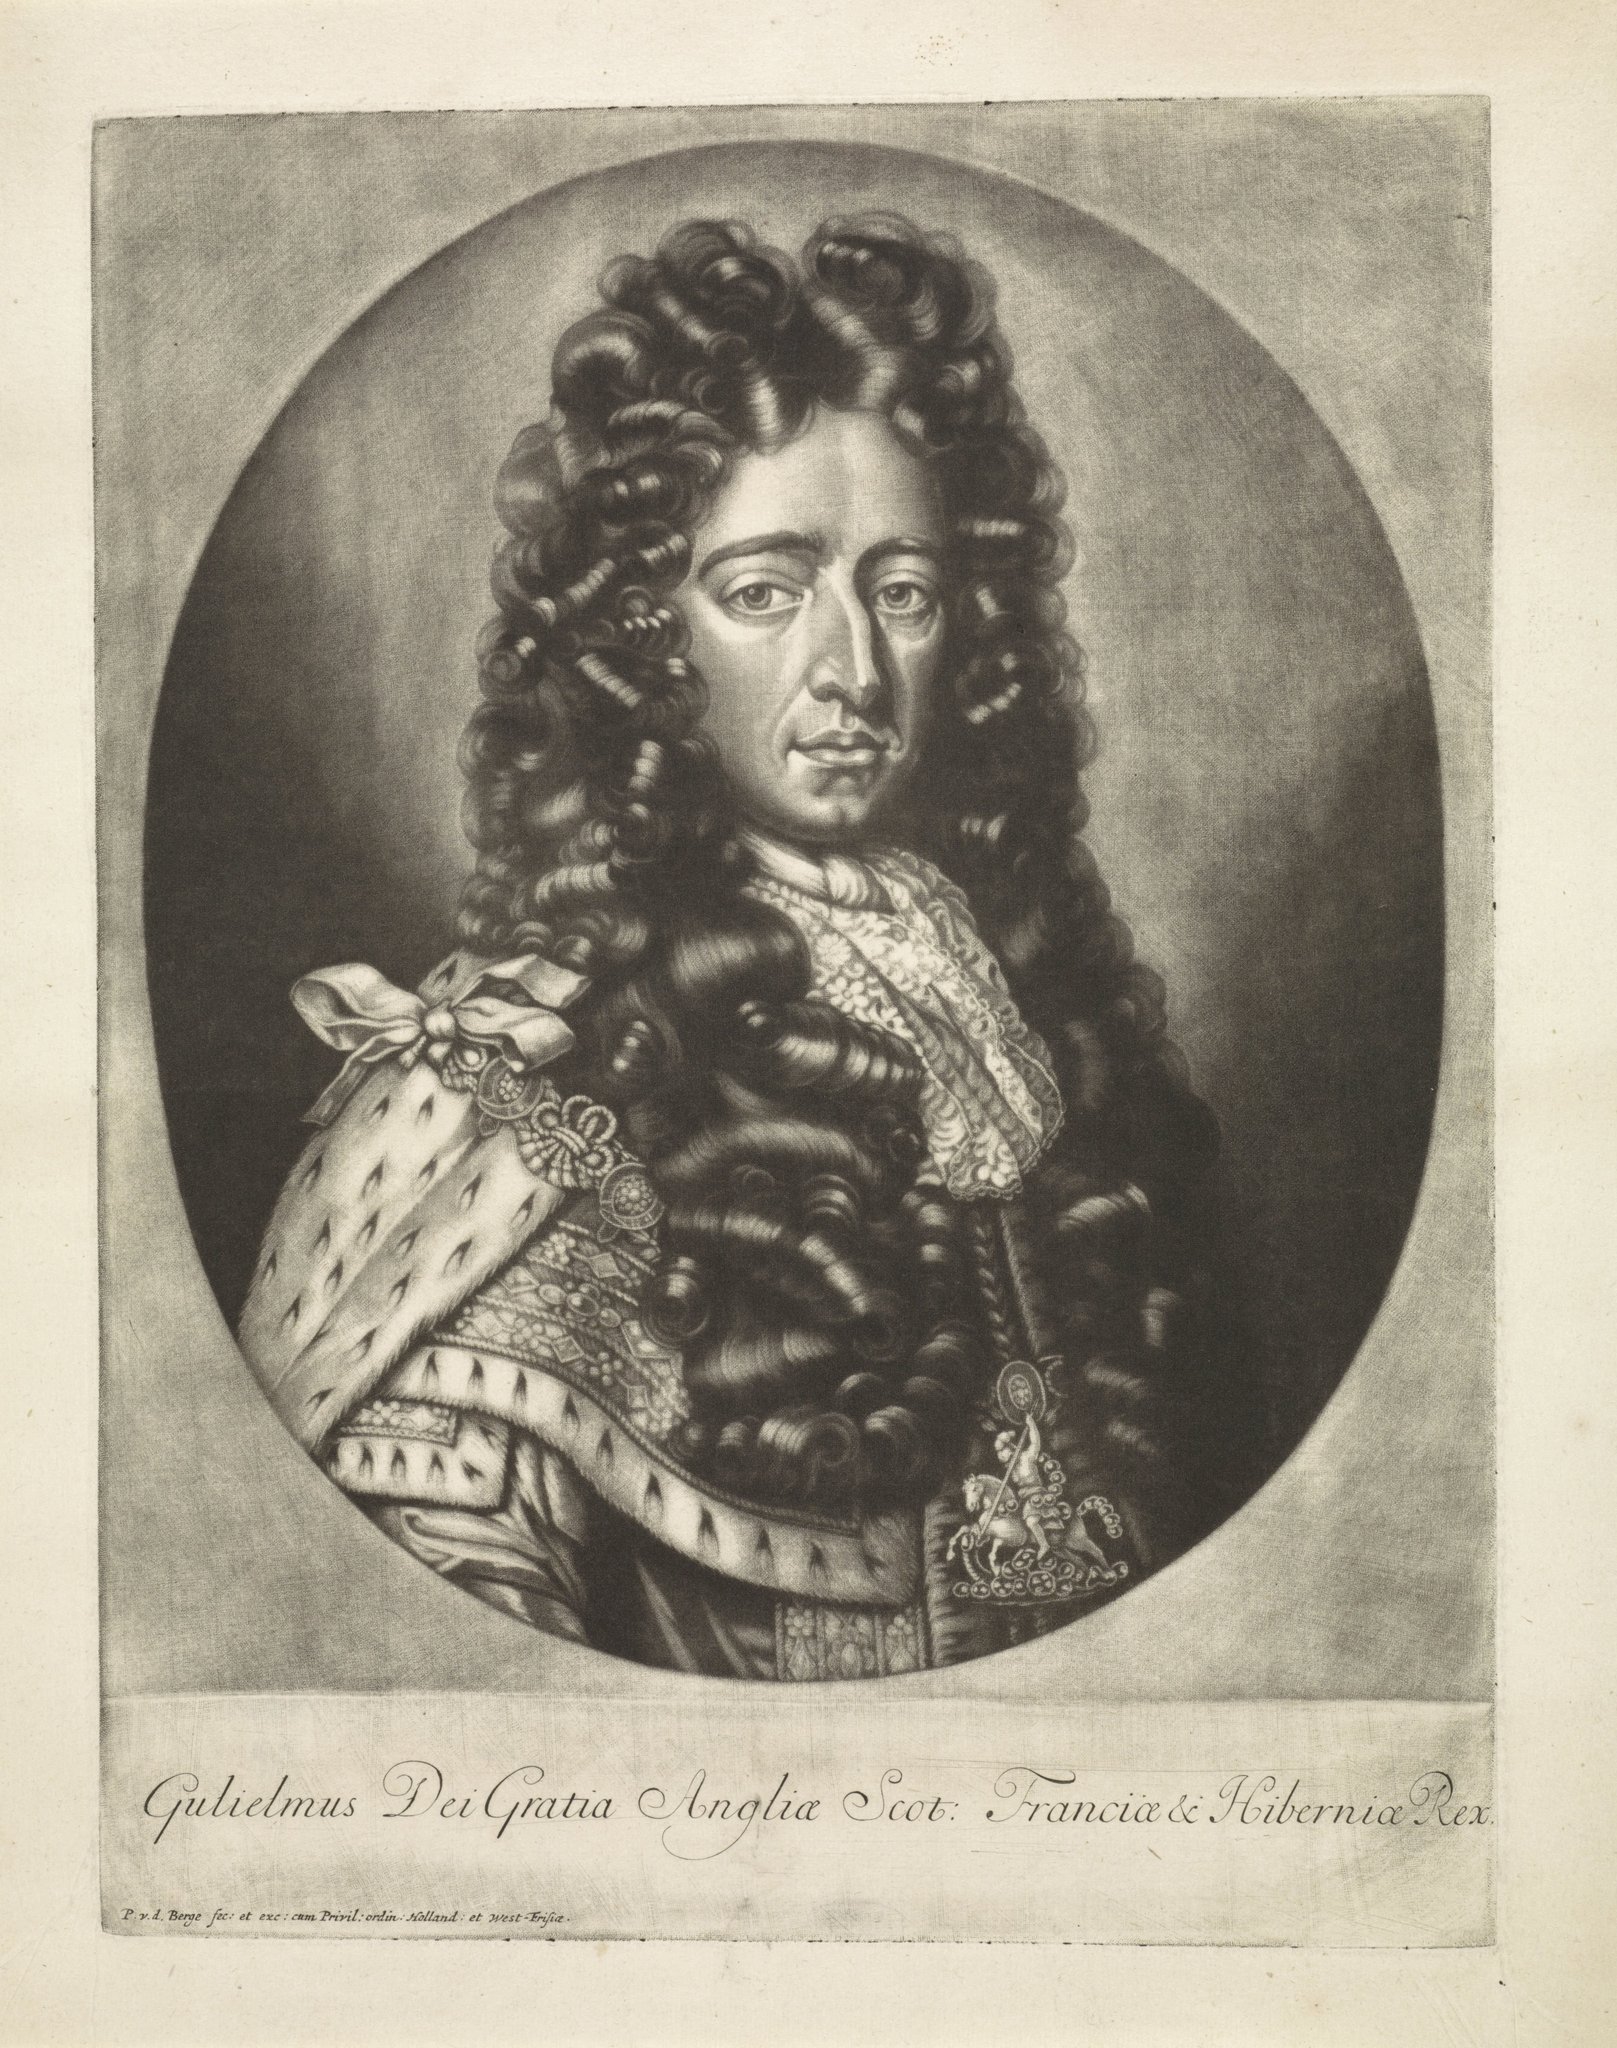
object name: print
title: Portret van Willem III, prins van Oranje-Nassau, koning van Engeland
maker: pieter van den berge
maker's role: draughtsman, print maker, printer, publisher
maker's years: 1659-1737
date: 1692-1737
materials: paper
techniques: engraving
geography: amsterdam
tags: william iii (prince of orange and king of england, scotland, and ireland), knighthood order (garter)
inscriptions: collector's mark: Lugt 2228, collector's mark: Lugt 2233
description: Portret van Willem III, prins van Oranje-Nassau en sinds 1689 koning van Engeland. Hij draagt het ordeteken van de Kousenband.